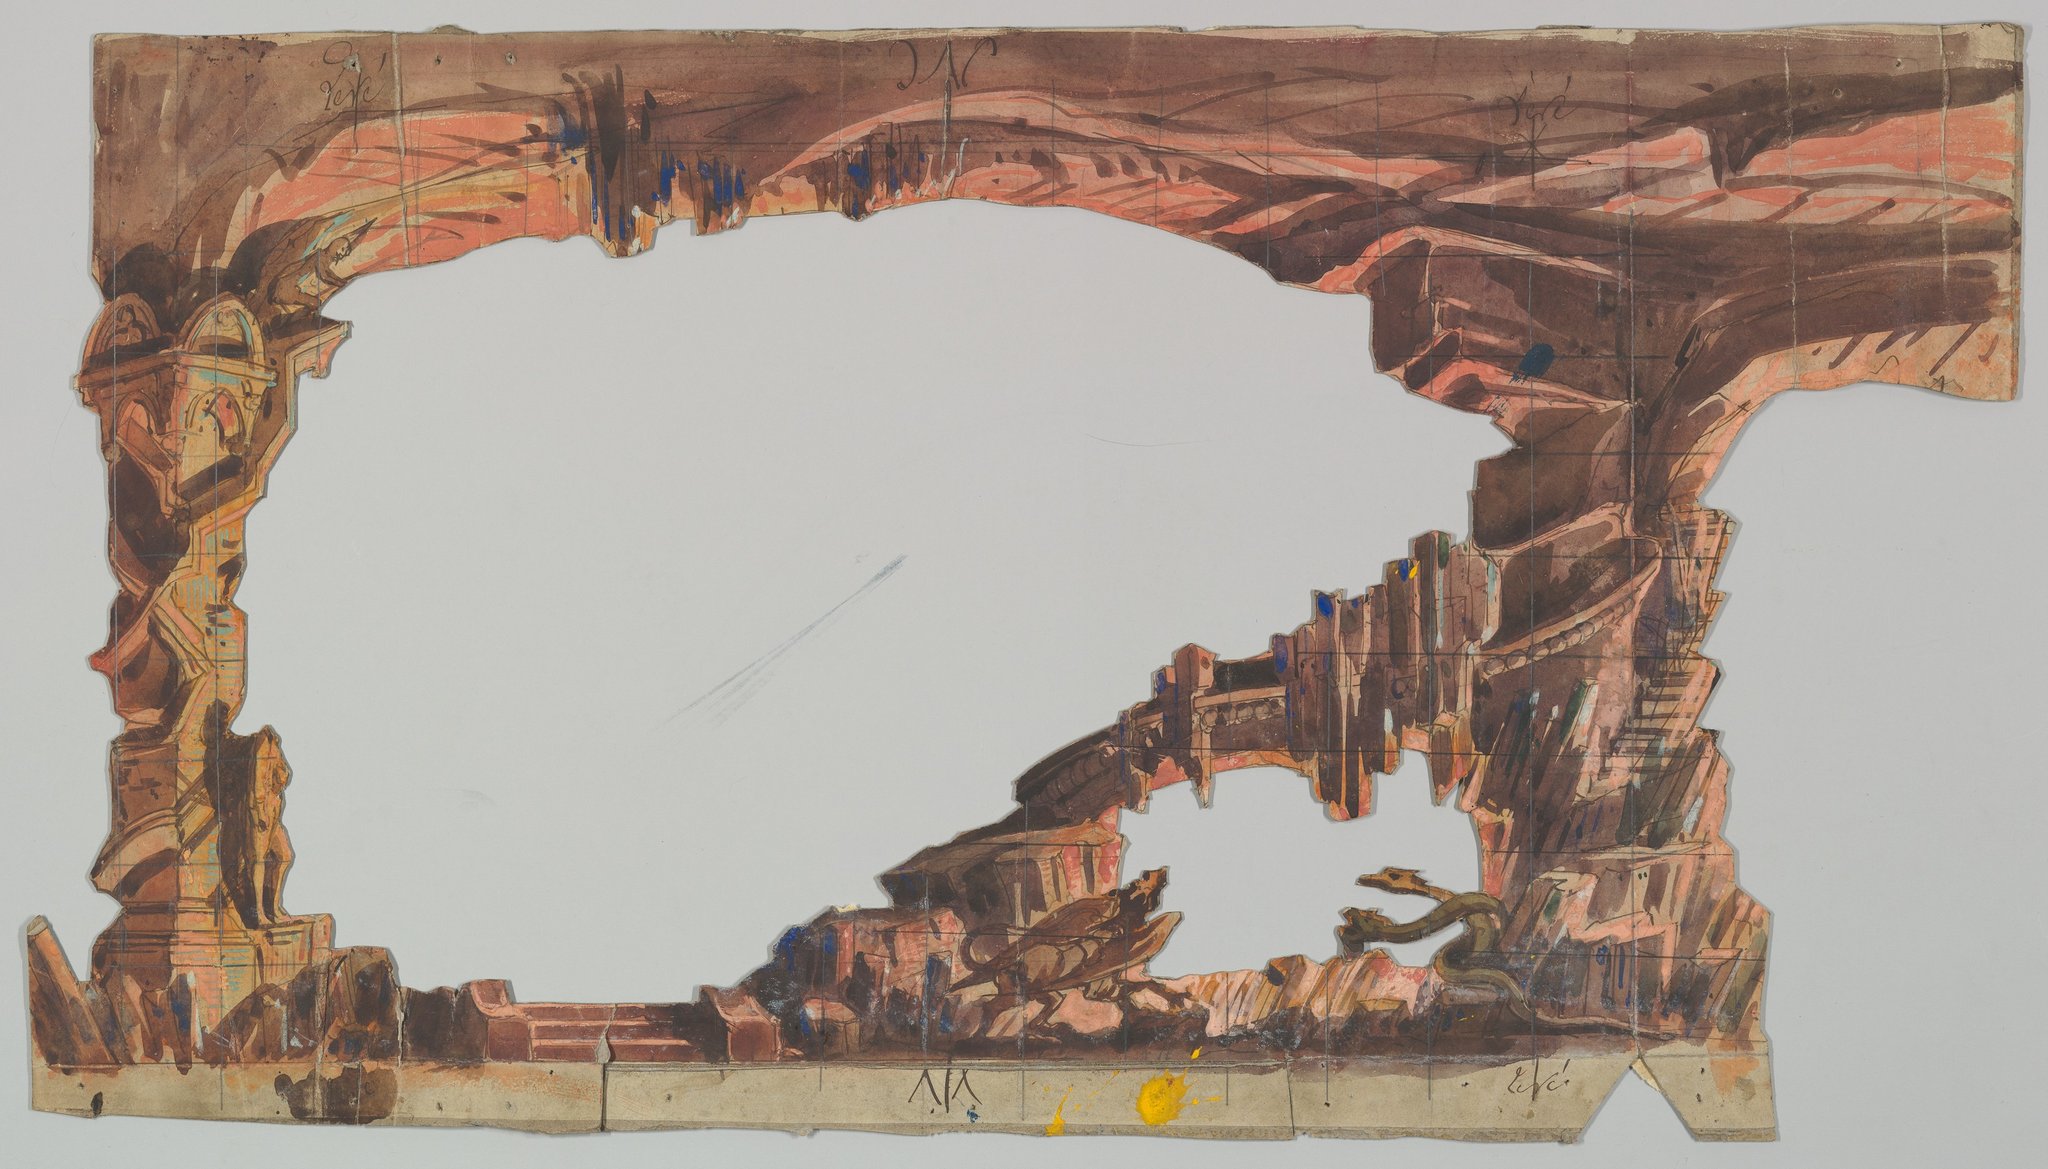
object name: drawing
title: Design for a Stage Set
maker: eugène cicéri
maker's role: artist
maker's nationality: french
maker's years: 1813-1890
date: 1830-1890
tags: stage design